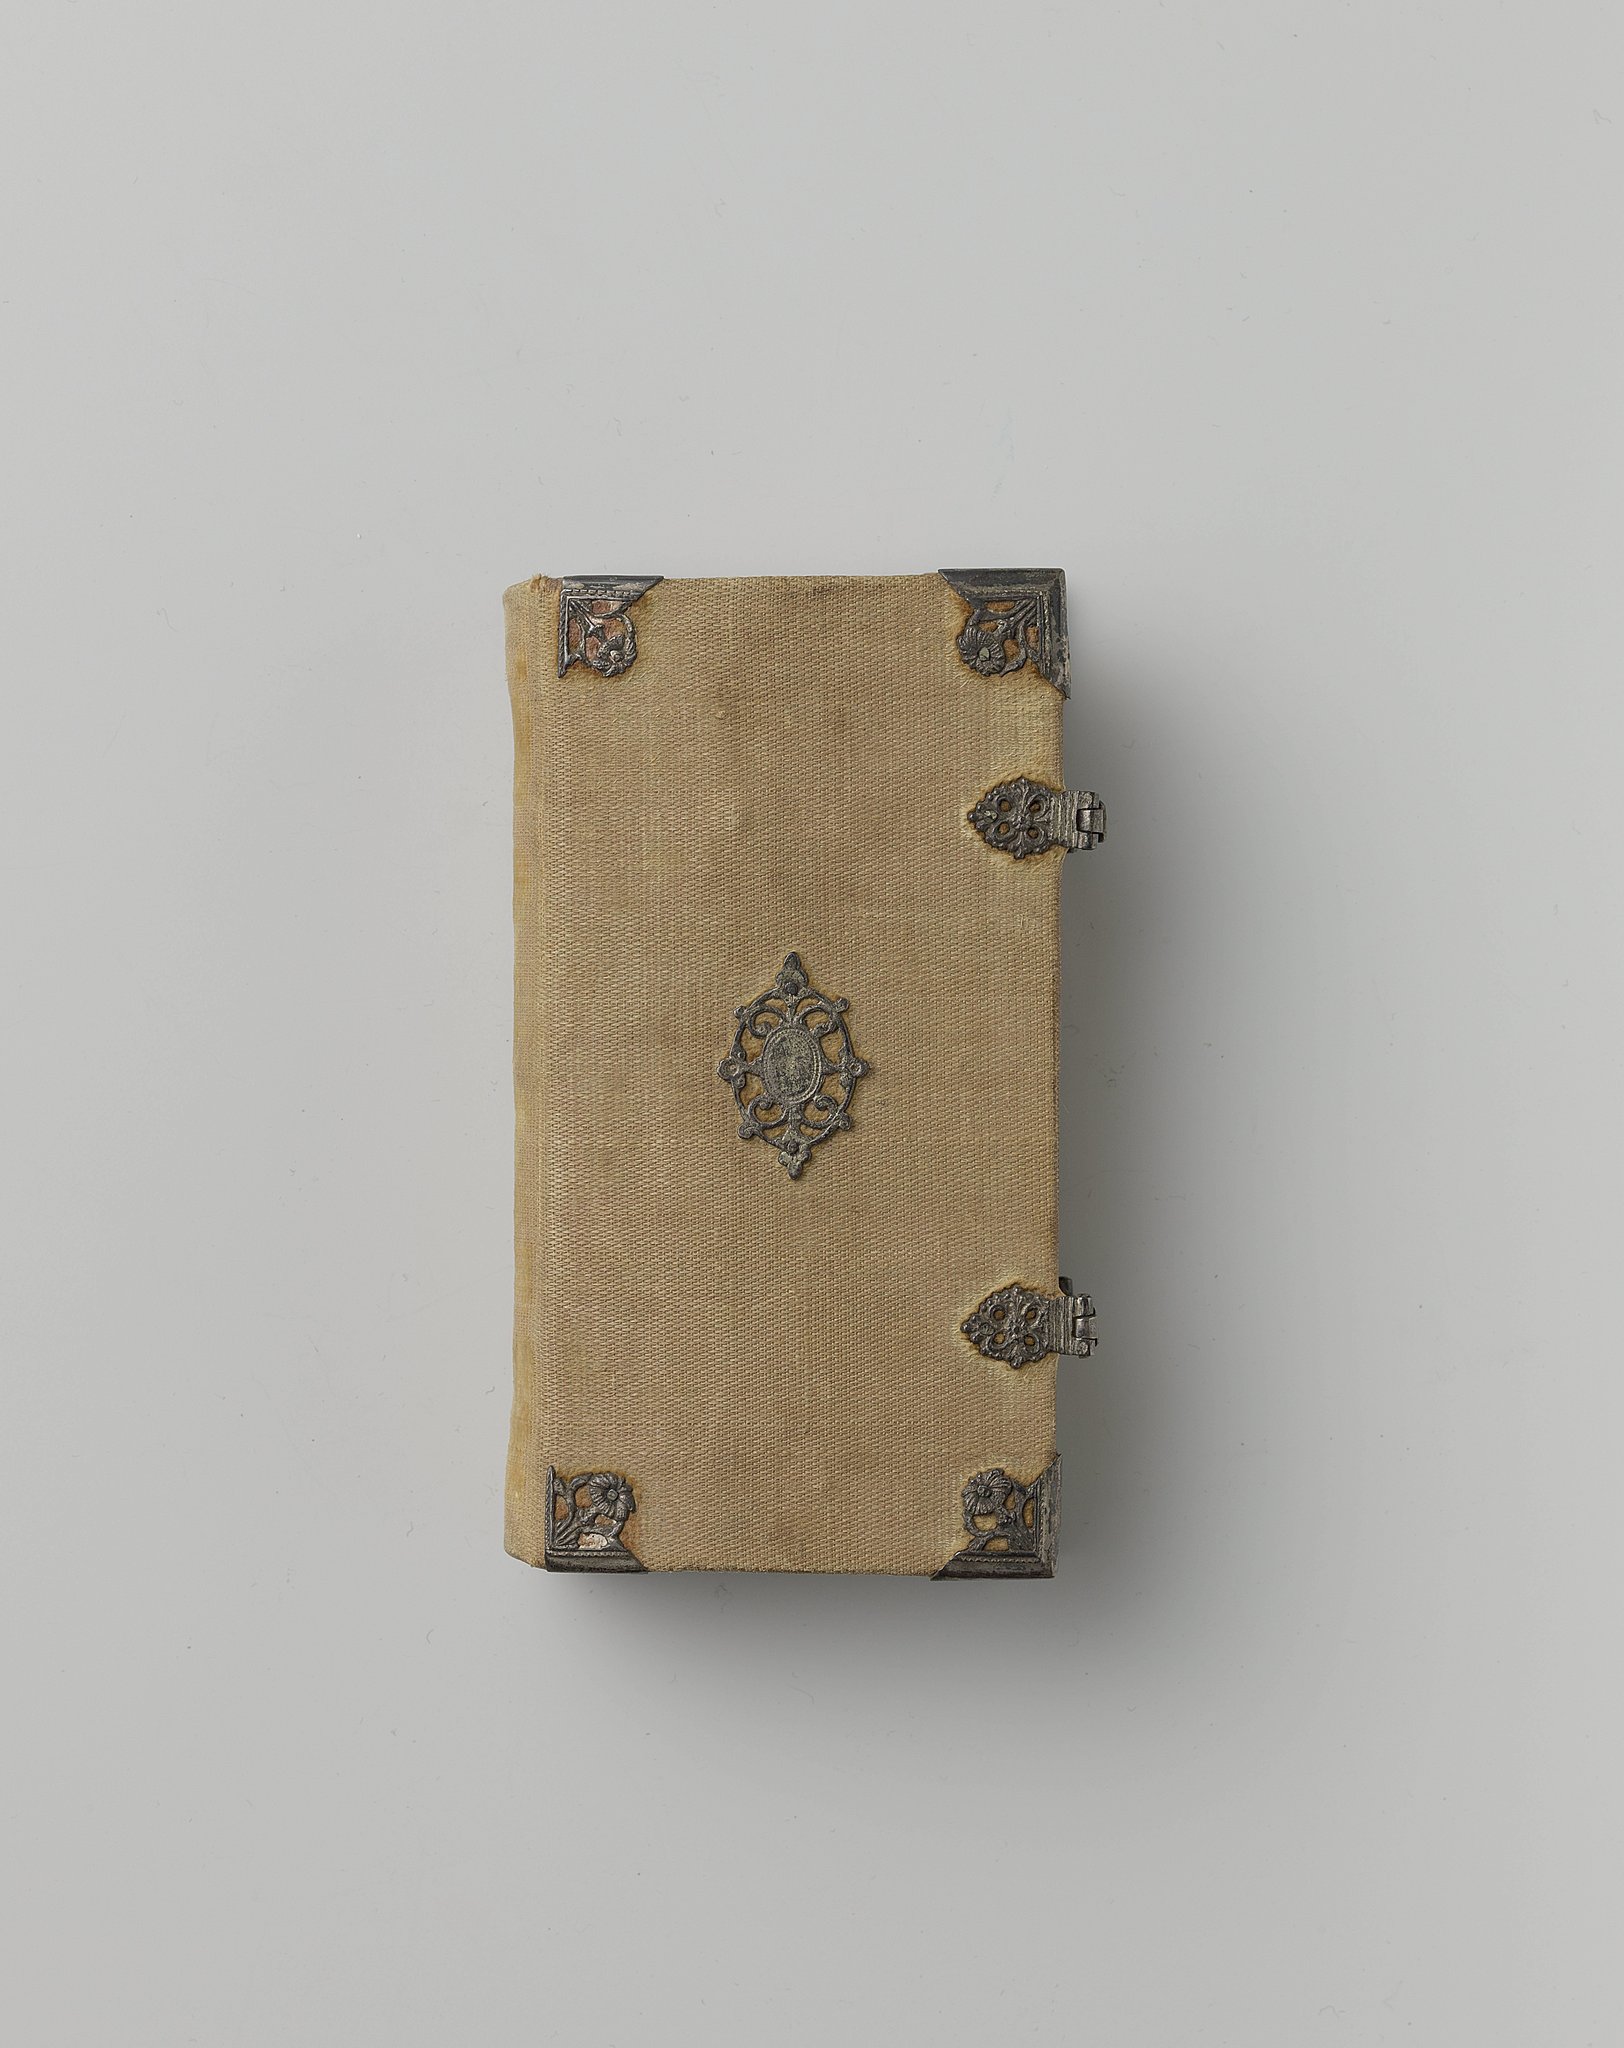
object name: book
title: Psalmboek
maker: Anonymous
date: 1599-1699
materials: silver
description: Een psalmboekje uit de 17de eeuw, gebonden in fluweel met fraai zilveren beslag.